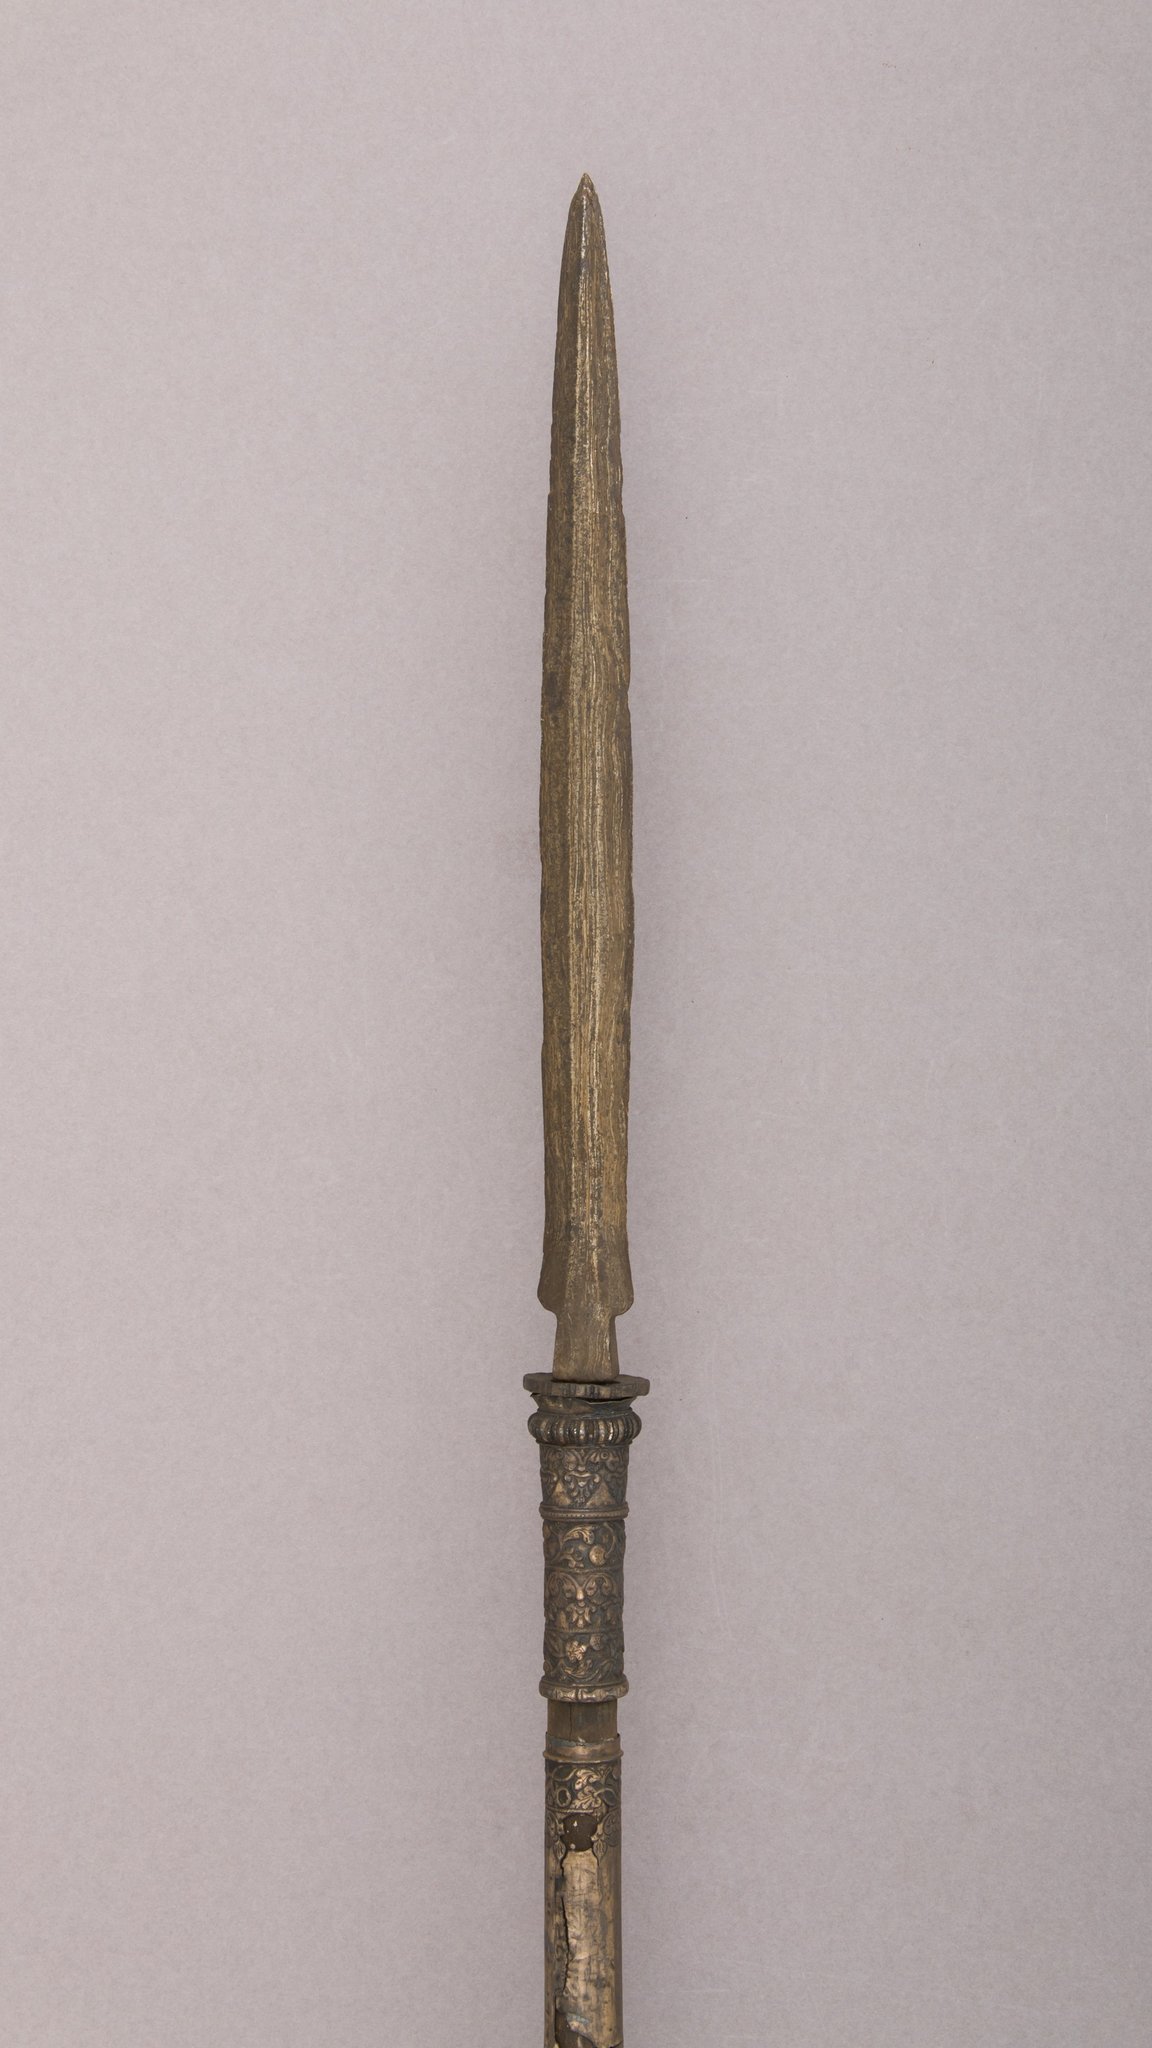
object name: spear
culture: madurese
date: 1701-1900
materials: hair, silver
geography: indonesia